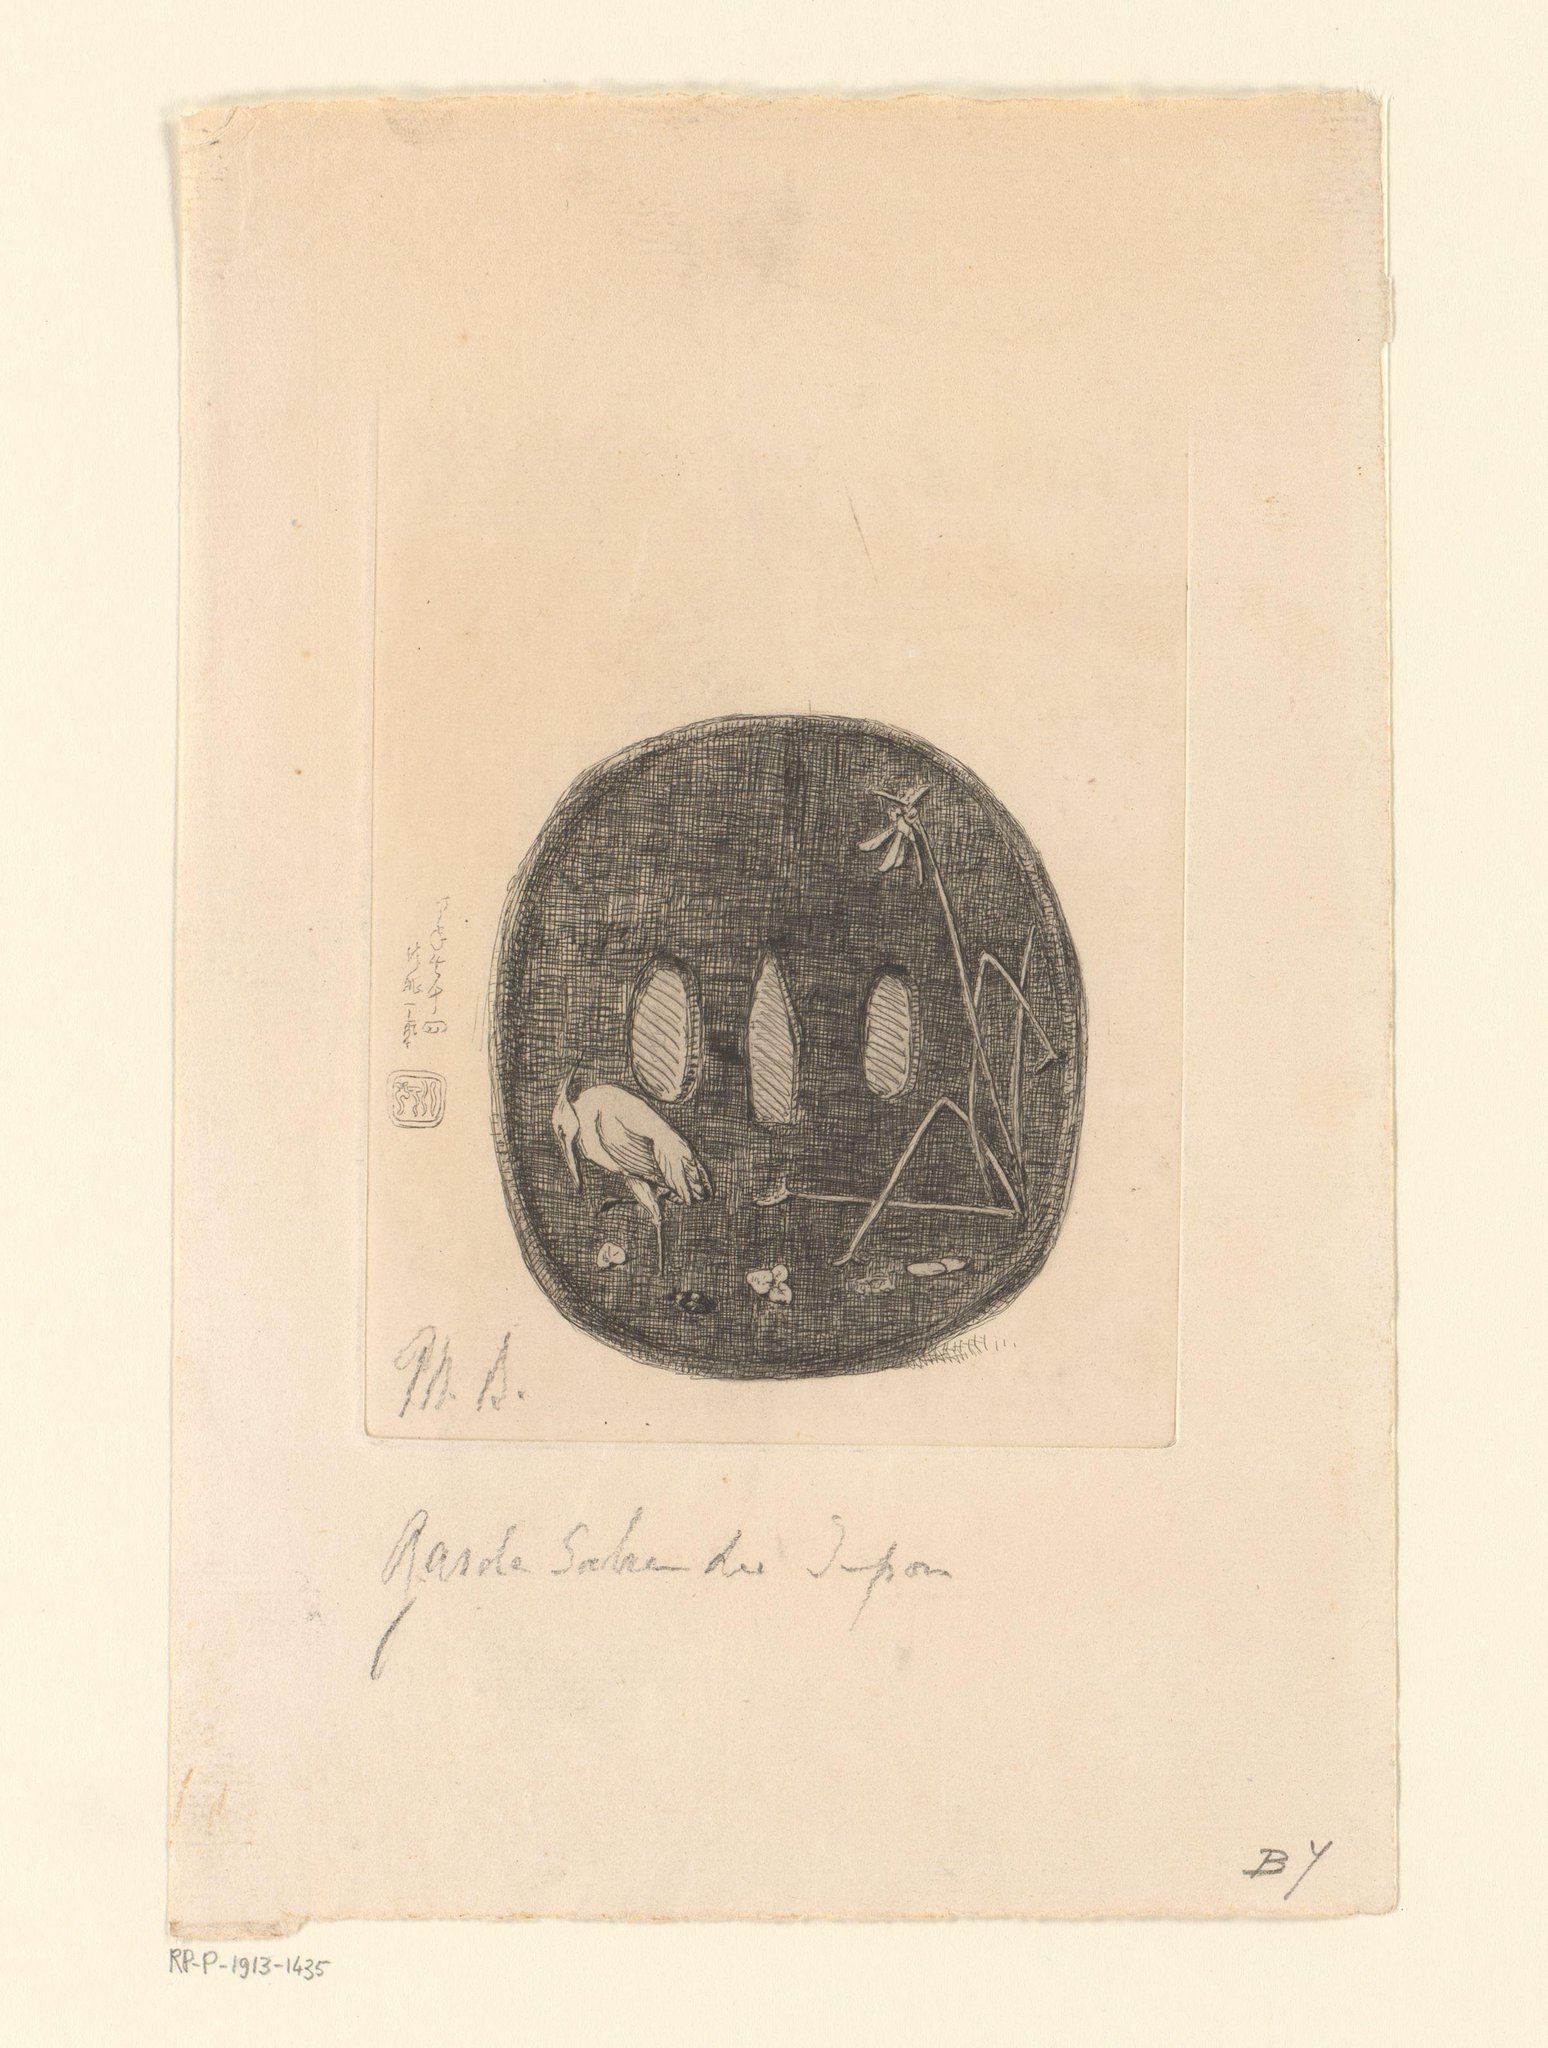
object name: print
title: Japanse stootplaat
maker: philippe burty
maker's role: print maker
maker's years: 1830-1890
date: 1840-1890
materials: paper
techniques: drypoint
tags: shore-birds and wading-birds: crane, hacking and thrusting weapons (with name)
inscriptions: inscription: ‘Garde sabre du Japon’, collector's mark: Lugt 2233